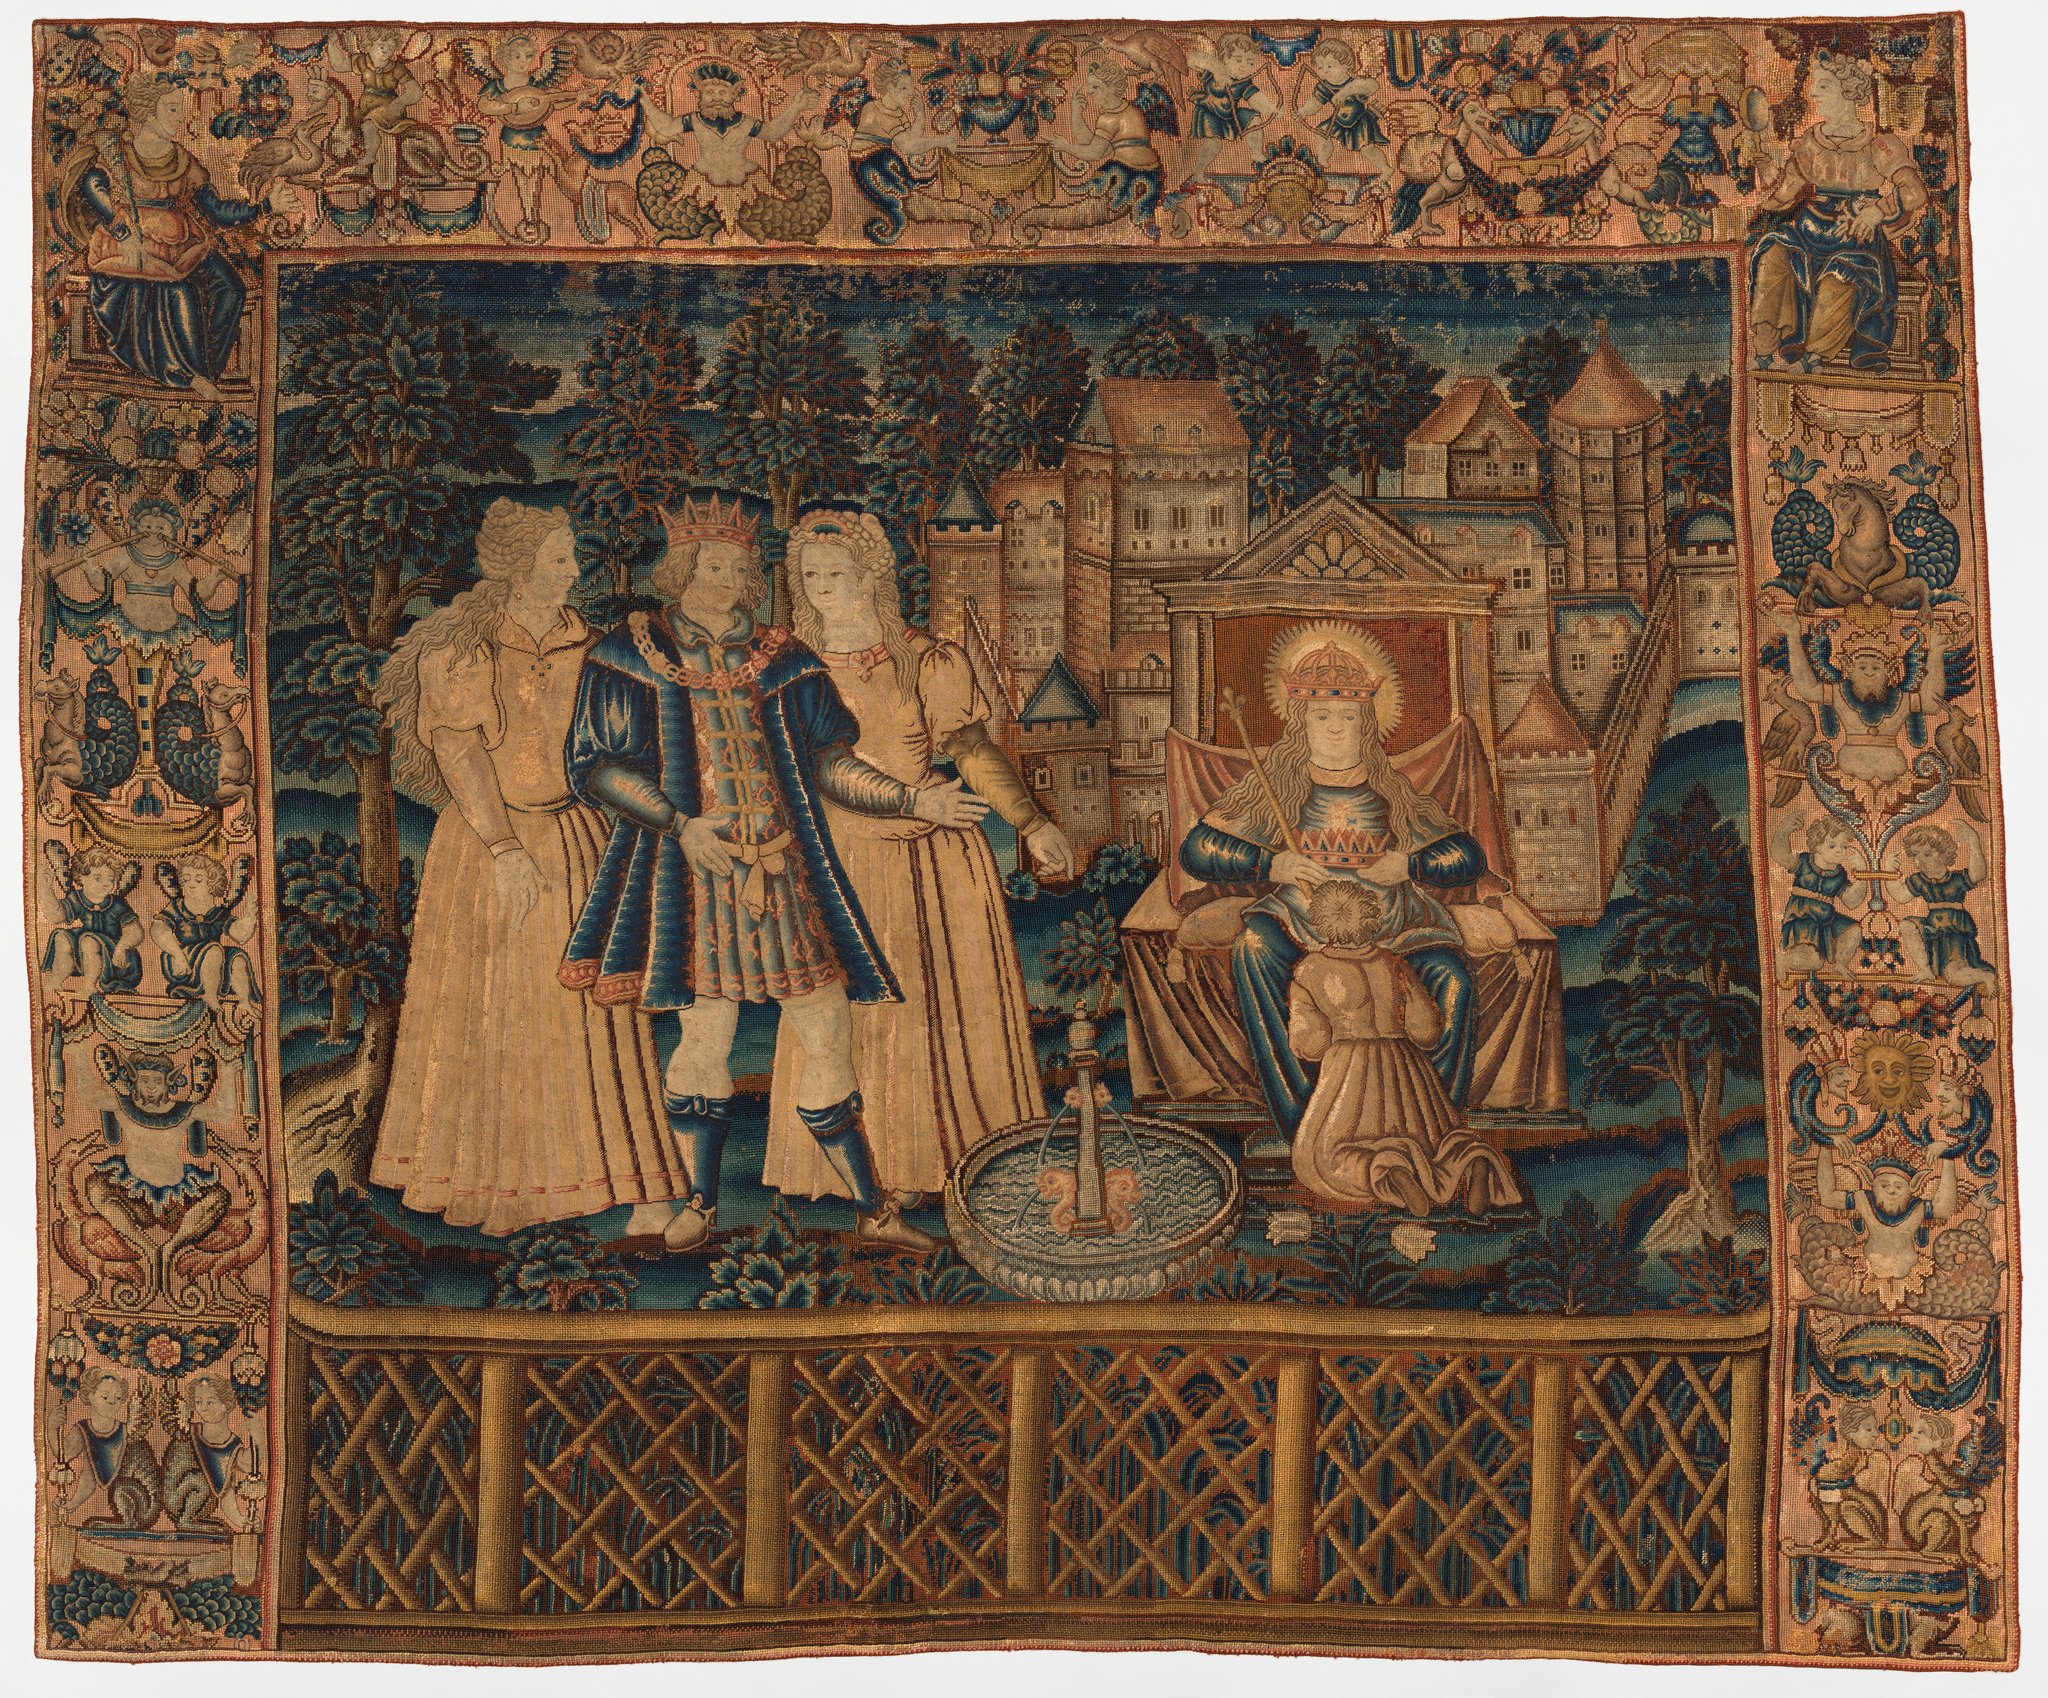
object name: hanging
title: The Wayfarer Crowned by Happiness from The Table of Cebes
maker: david kandel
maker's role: designer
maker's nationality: german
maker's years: 1515-1601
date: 1550-1580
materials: canvas, silk, wool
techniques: stitching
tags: fountains,men,women,crowns